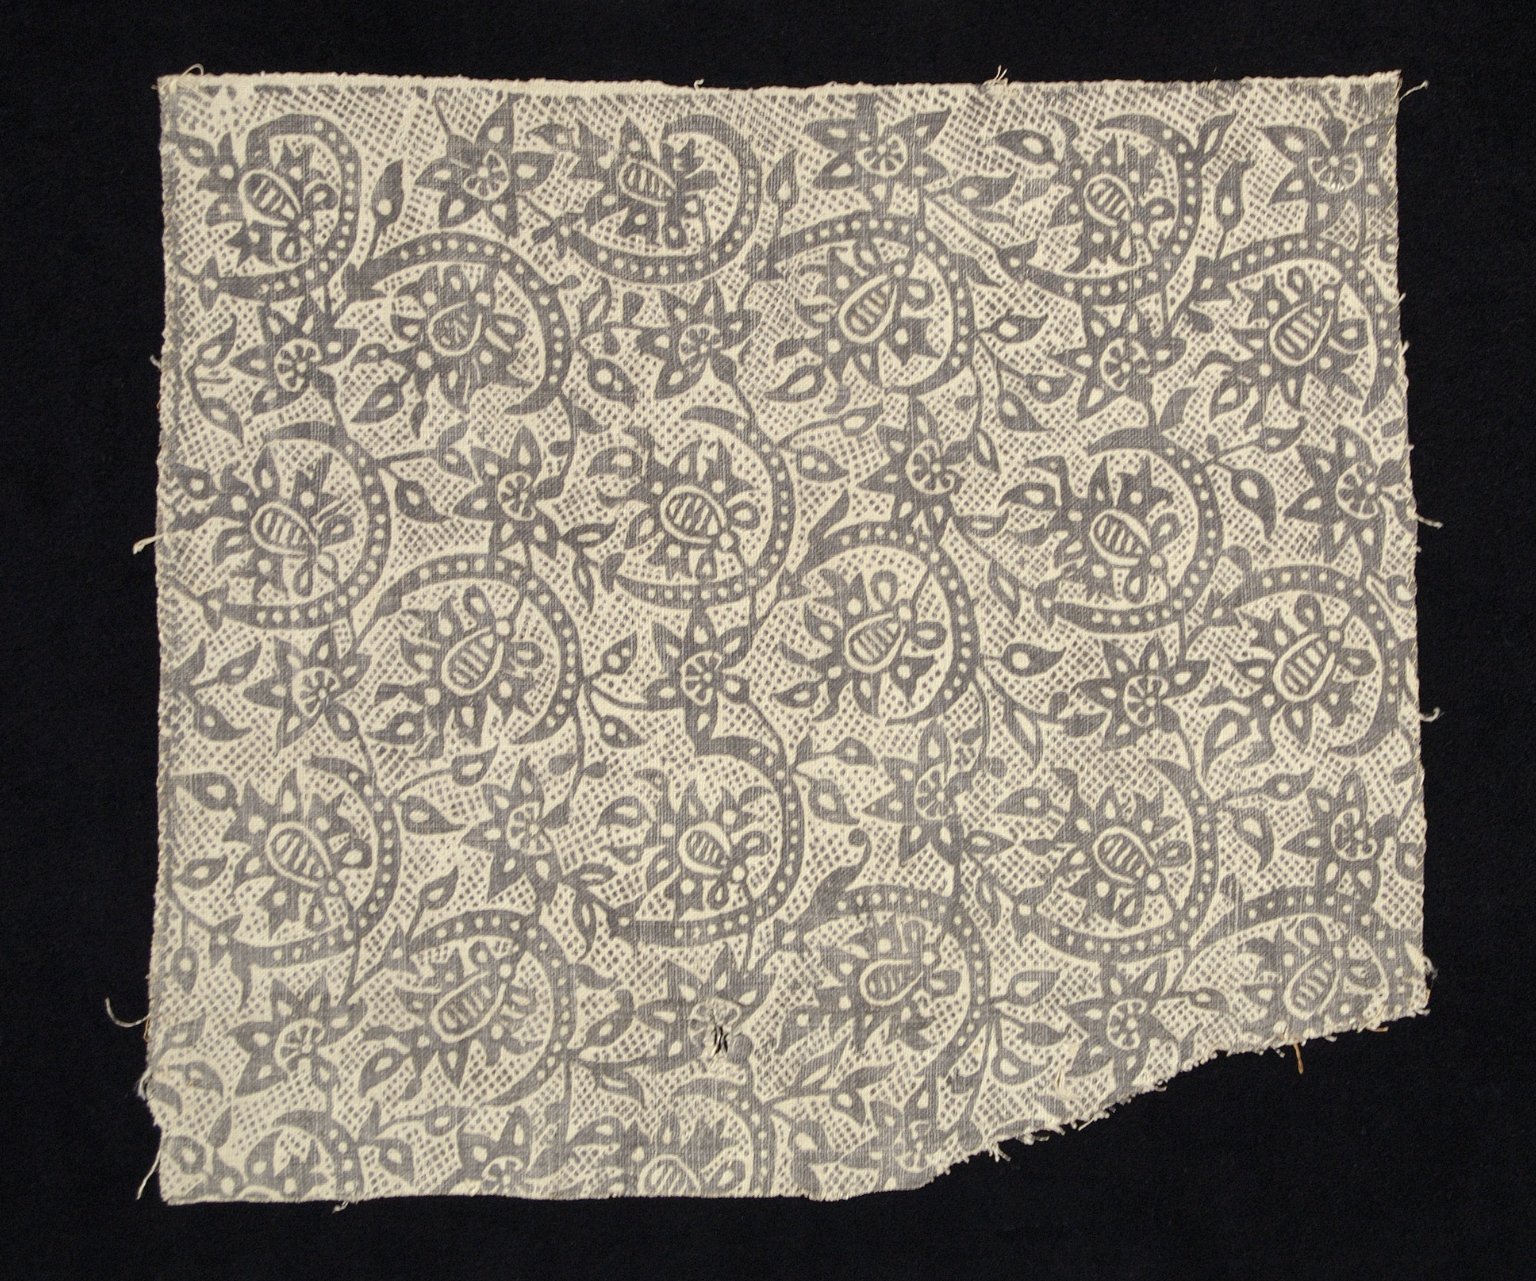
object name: textile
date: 1700-1899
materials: linen